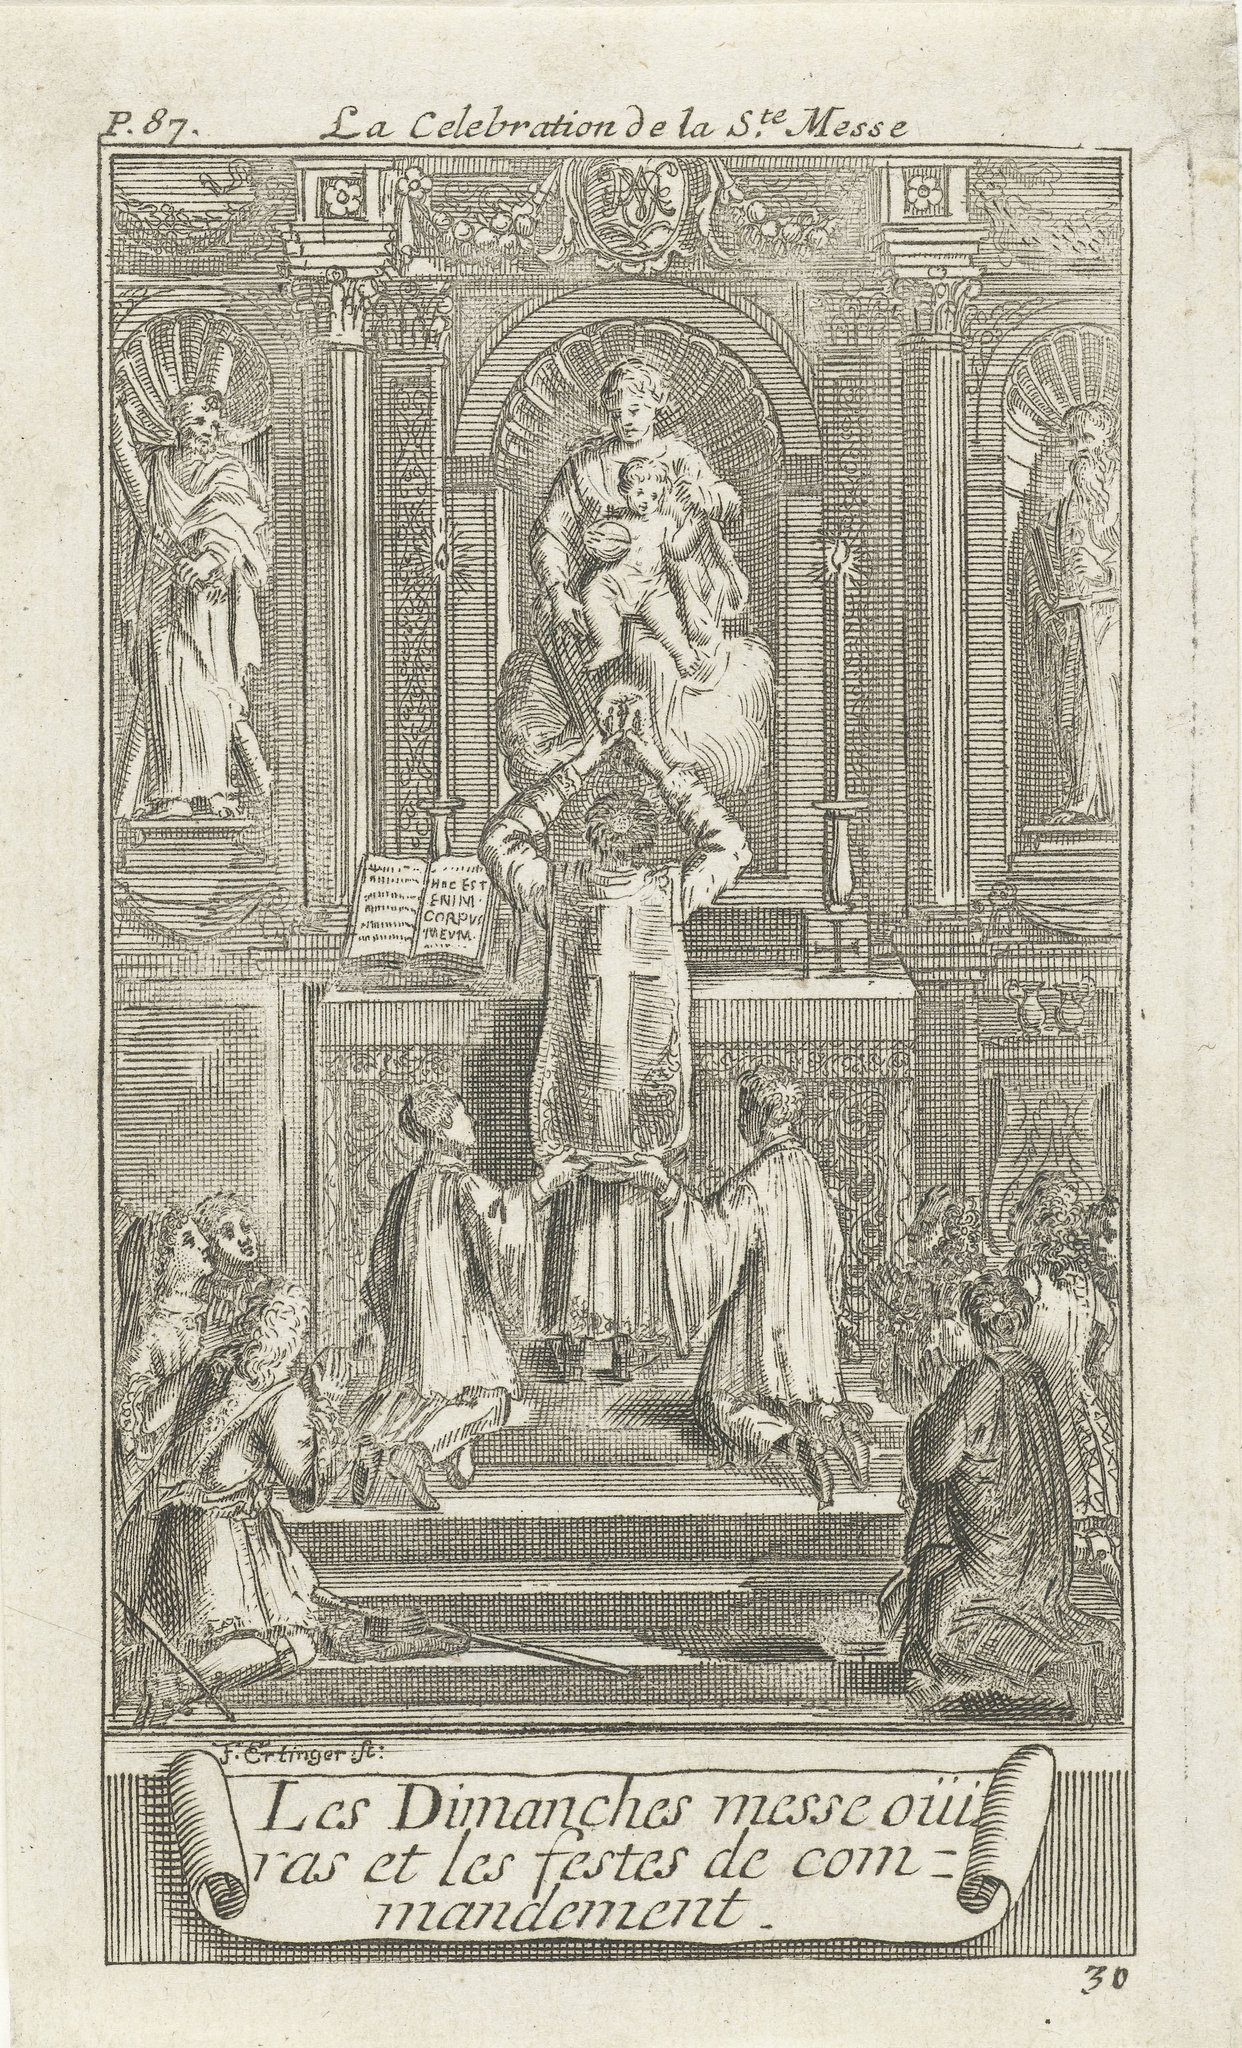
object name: print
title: La celebration de la Ste Messe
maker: franz ertinger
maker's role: print maker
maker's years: 1640-1710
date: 1650-1710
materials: paper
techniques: engraving, etching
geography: paris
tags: sermon ~ holy mass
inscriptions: collector's mark: Lugt 2228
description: Een priester, op de rug gezien, toont de hostie bij het altaar. Boven het altaar een beeld van Maria met kind. Op de voorgrond geknielde gelovigen. Onder de voorstelling een banderol met drie regels Frans. Rechtsonder het getal 30.